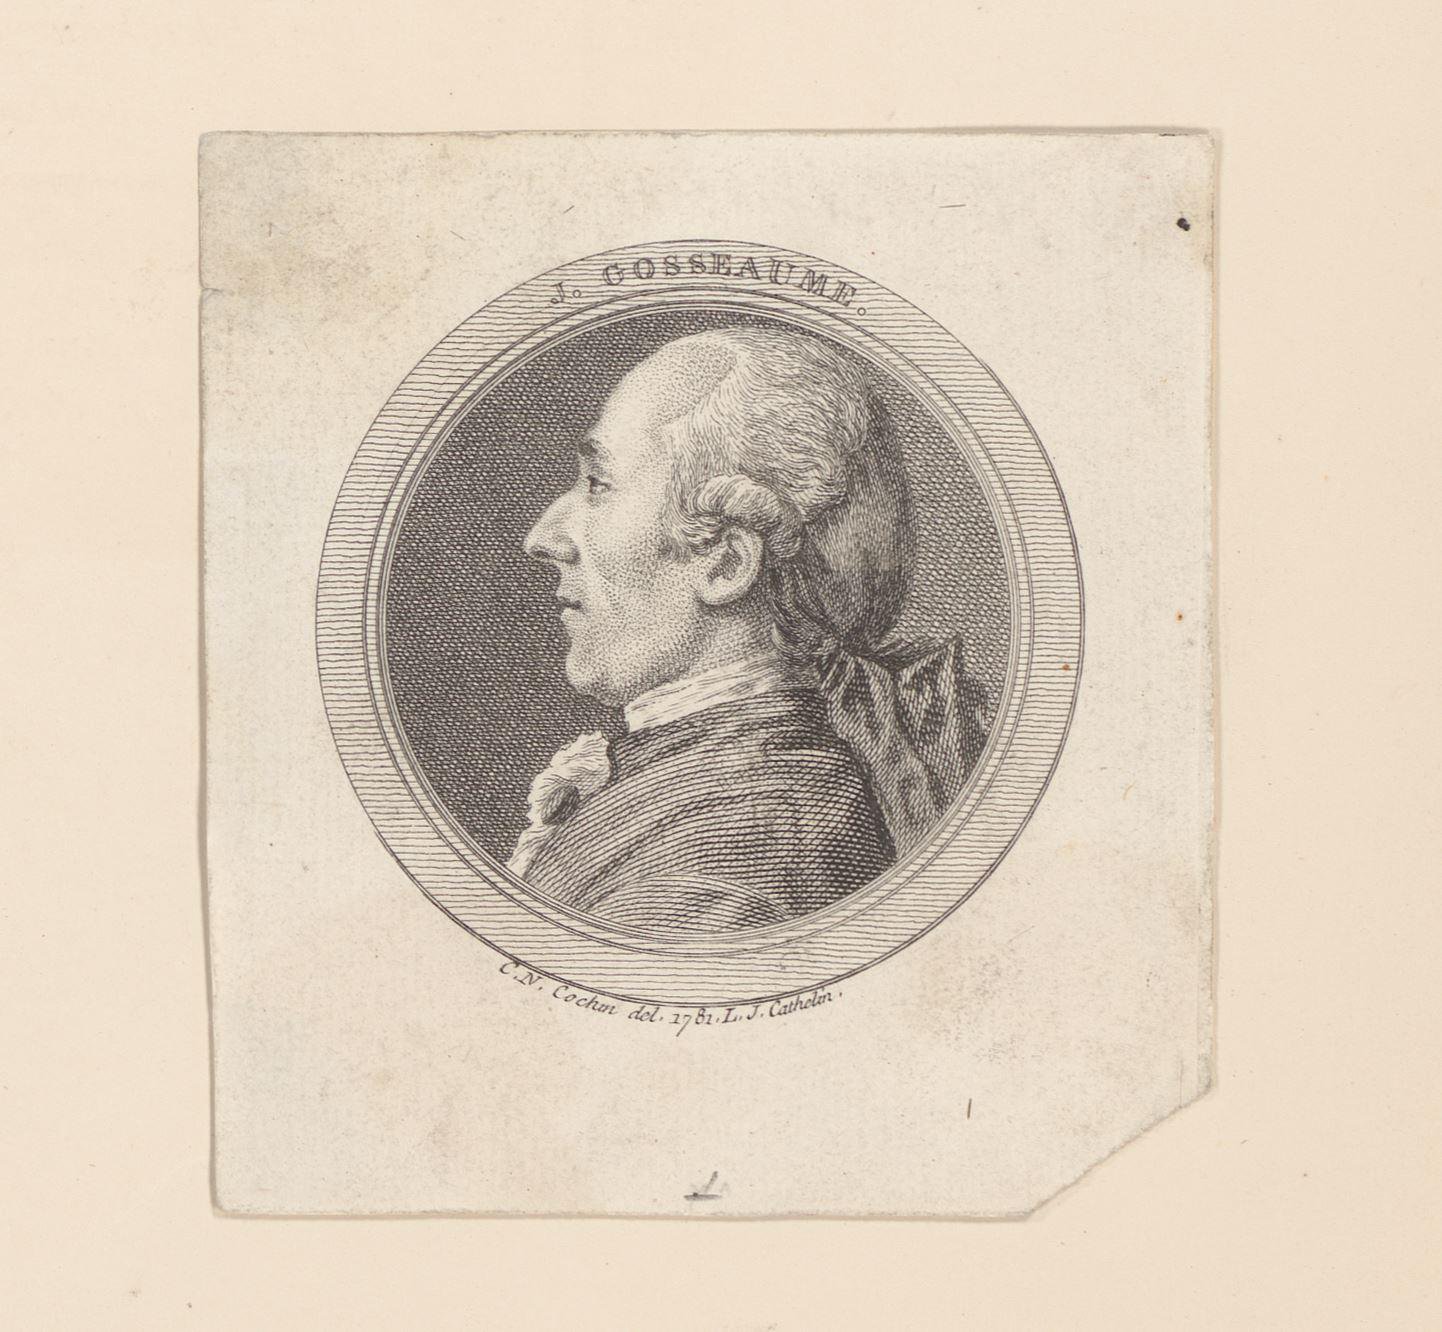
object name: print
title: J. Gosseaume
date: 1781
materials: paper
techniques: engraving, etching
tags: historical persons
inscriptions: date